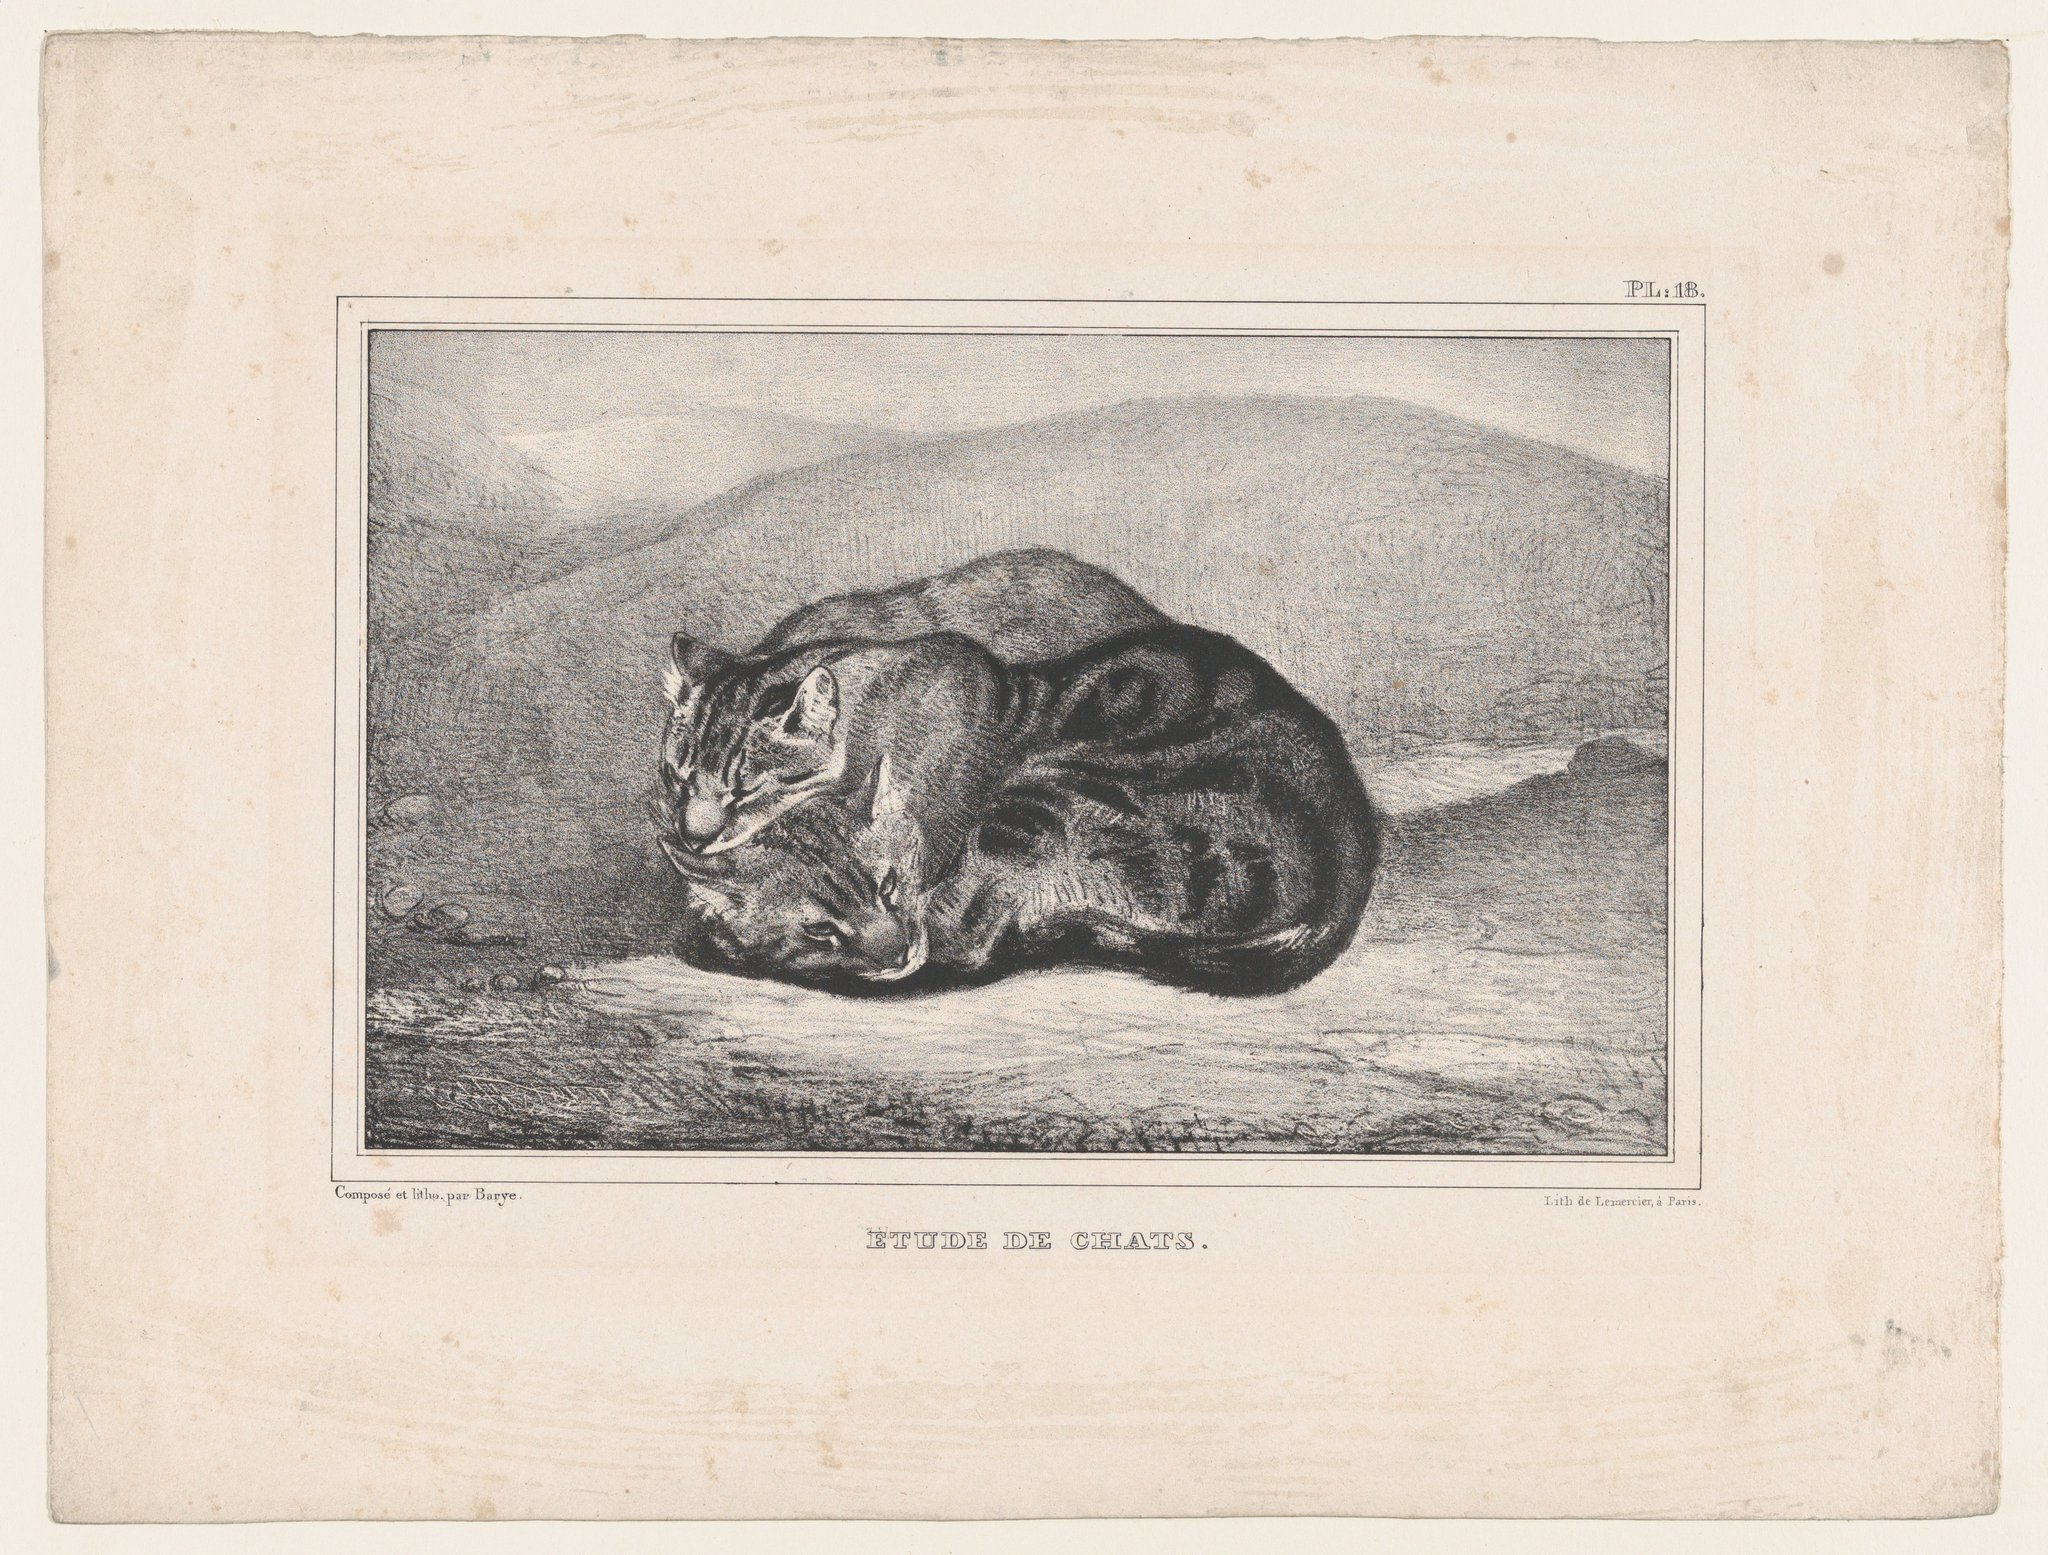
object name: print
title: Study of Cats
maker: antoine-louis barye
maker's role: artist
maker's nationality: french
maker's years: 1795-1875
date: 1836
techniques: lithograph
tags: cats